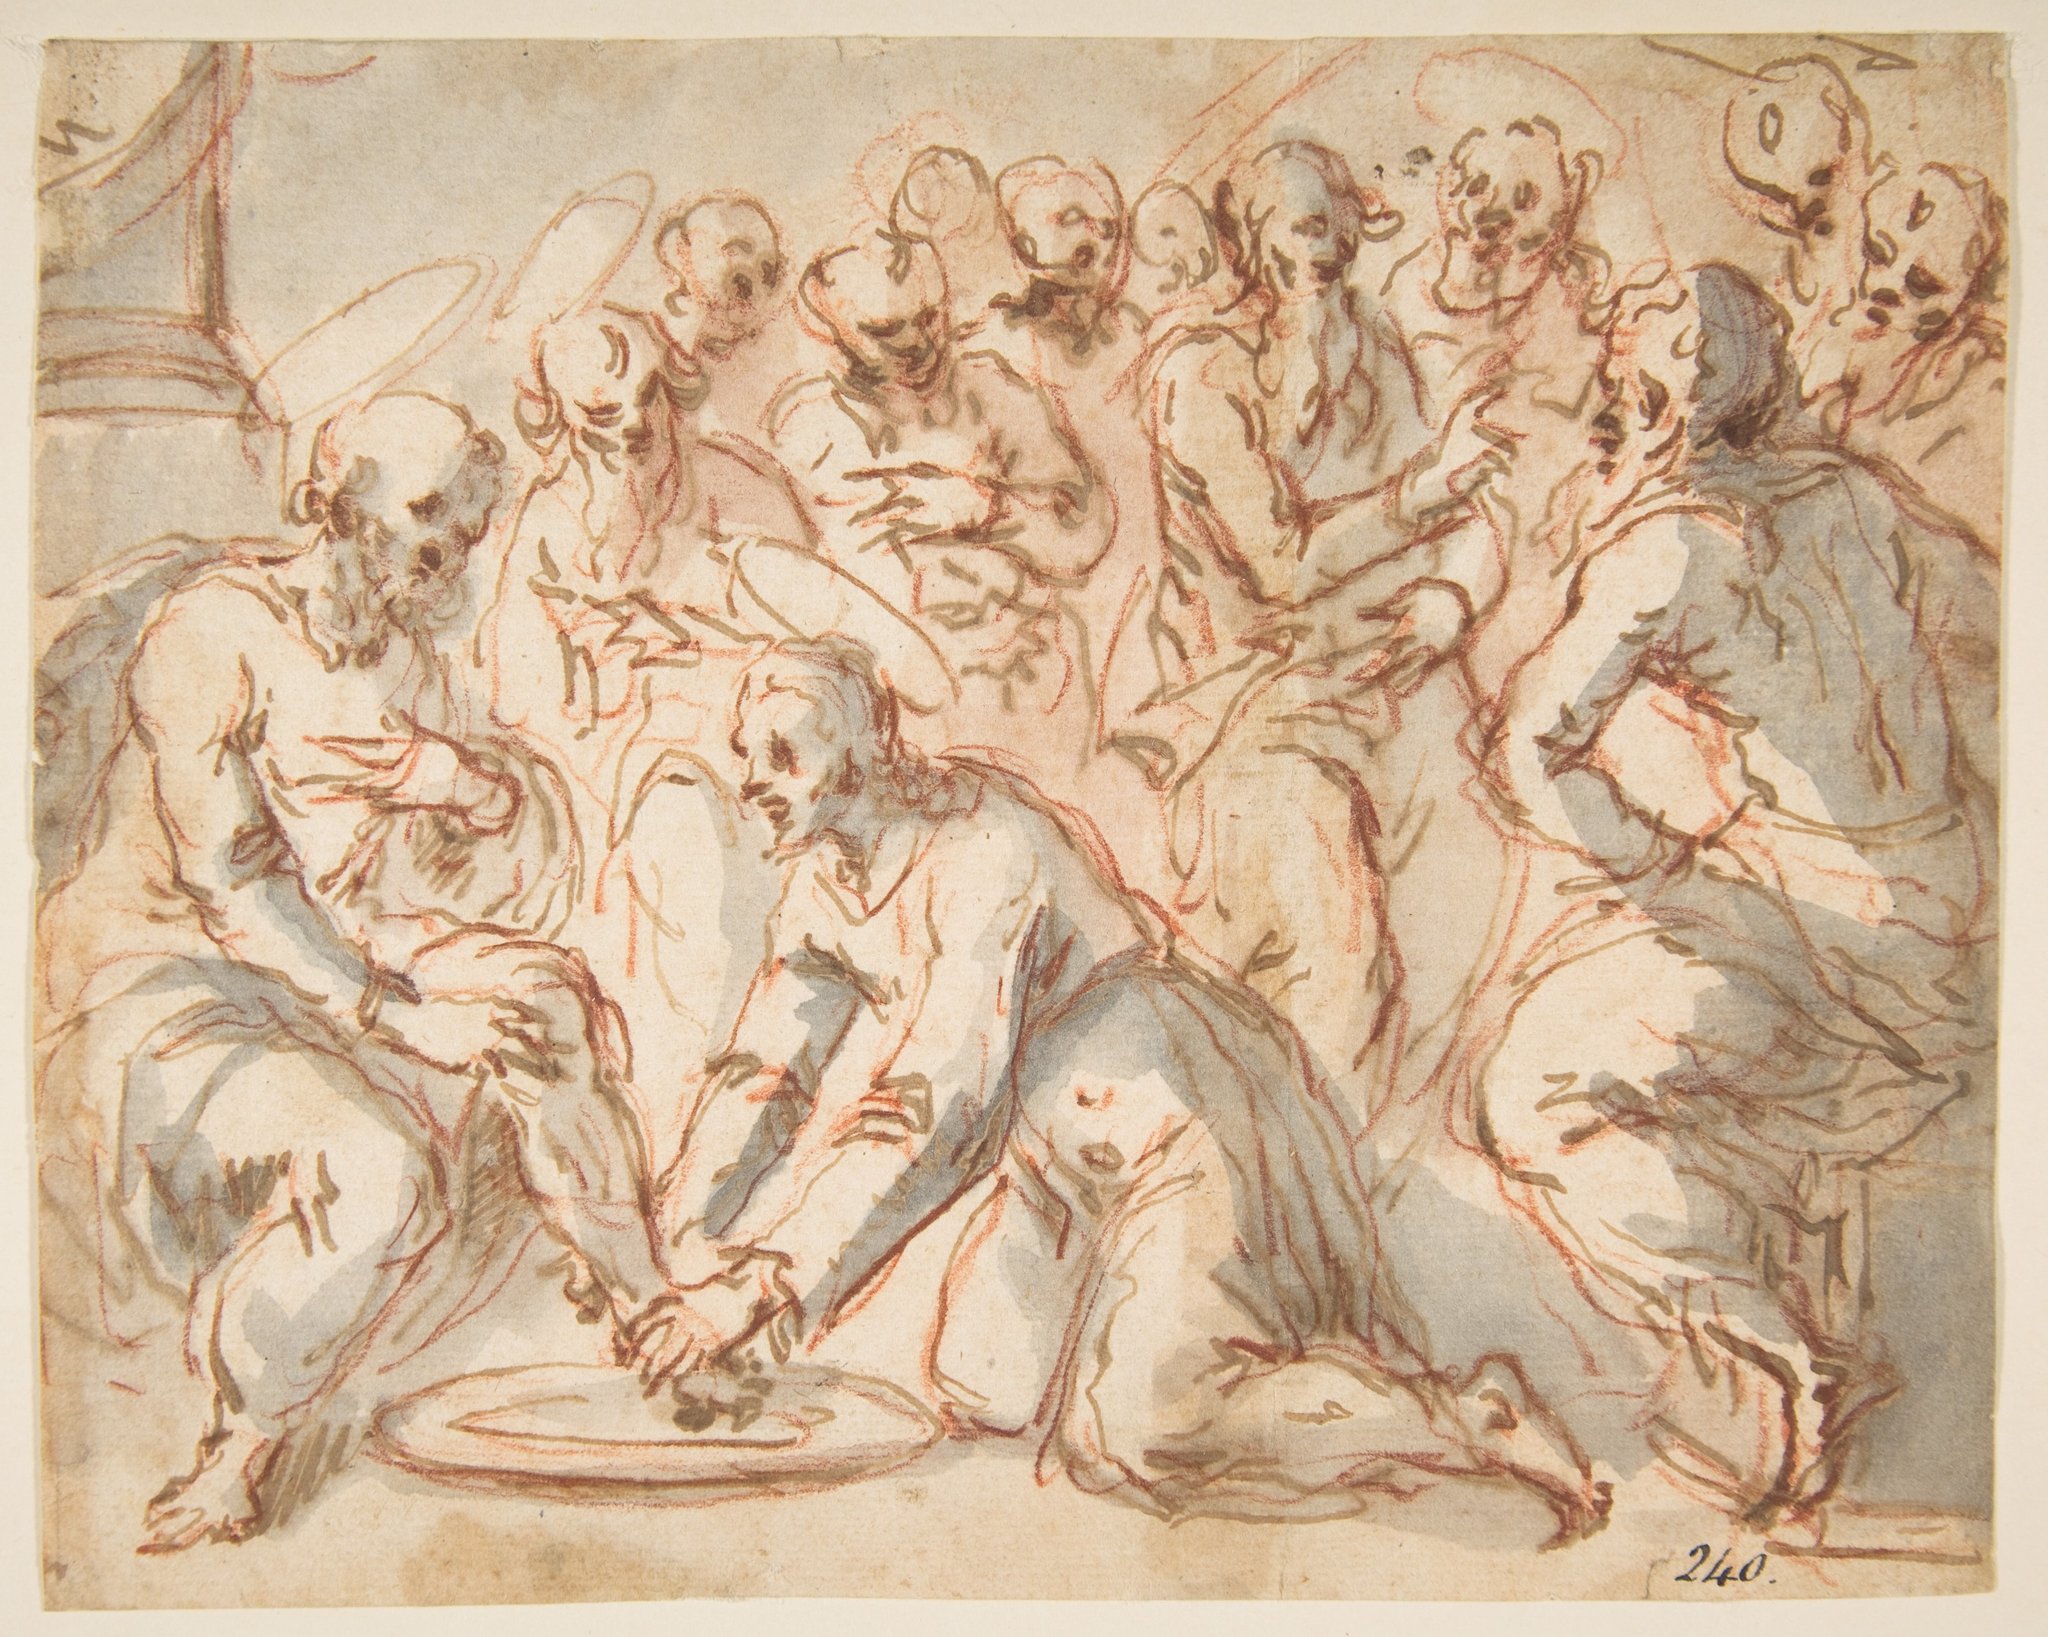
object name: drawing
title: Christ Washing the Disciples' Feet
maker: francesco vanni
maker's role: artist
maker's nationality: italian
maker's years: 1563-1610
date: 1583-1610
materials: chalk, ink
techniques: pen, wash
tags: human figures,christ